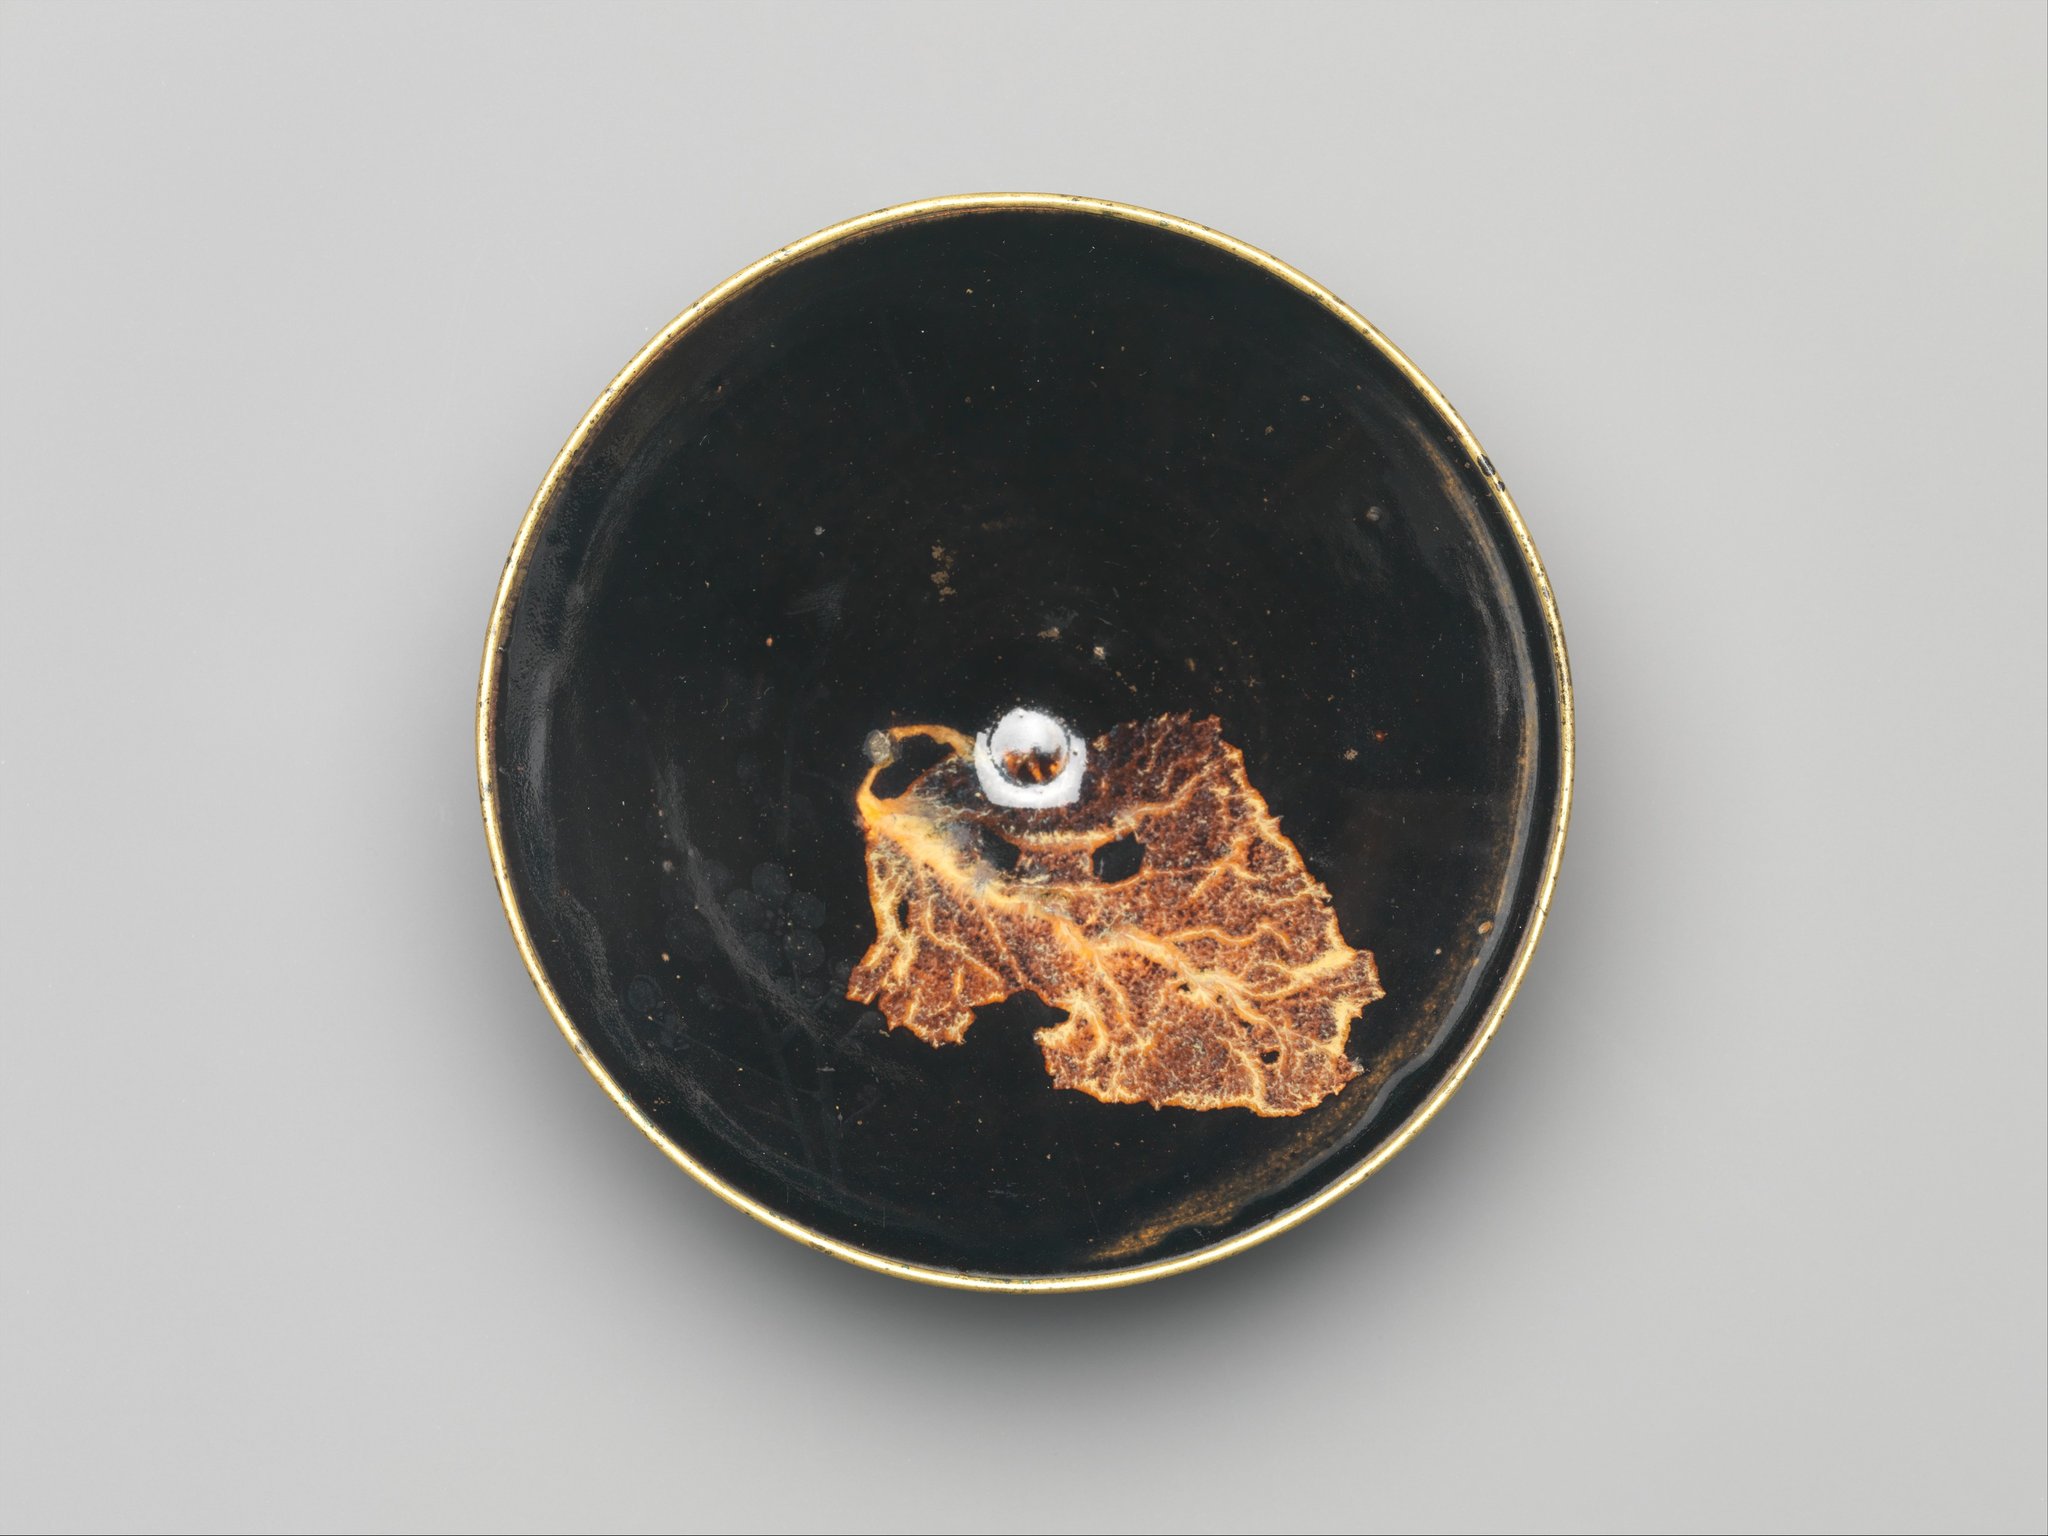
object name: bowl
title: Tea Bowl with Leaf Decoration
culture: chinese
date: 1101-1300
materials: glaze, pigment, stoneware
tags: leaves